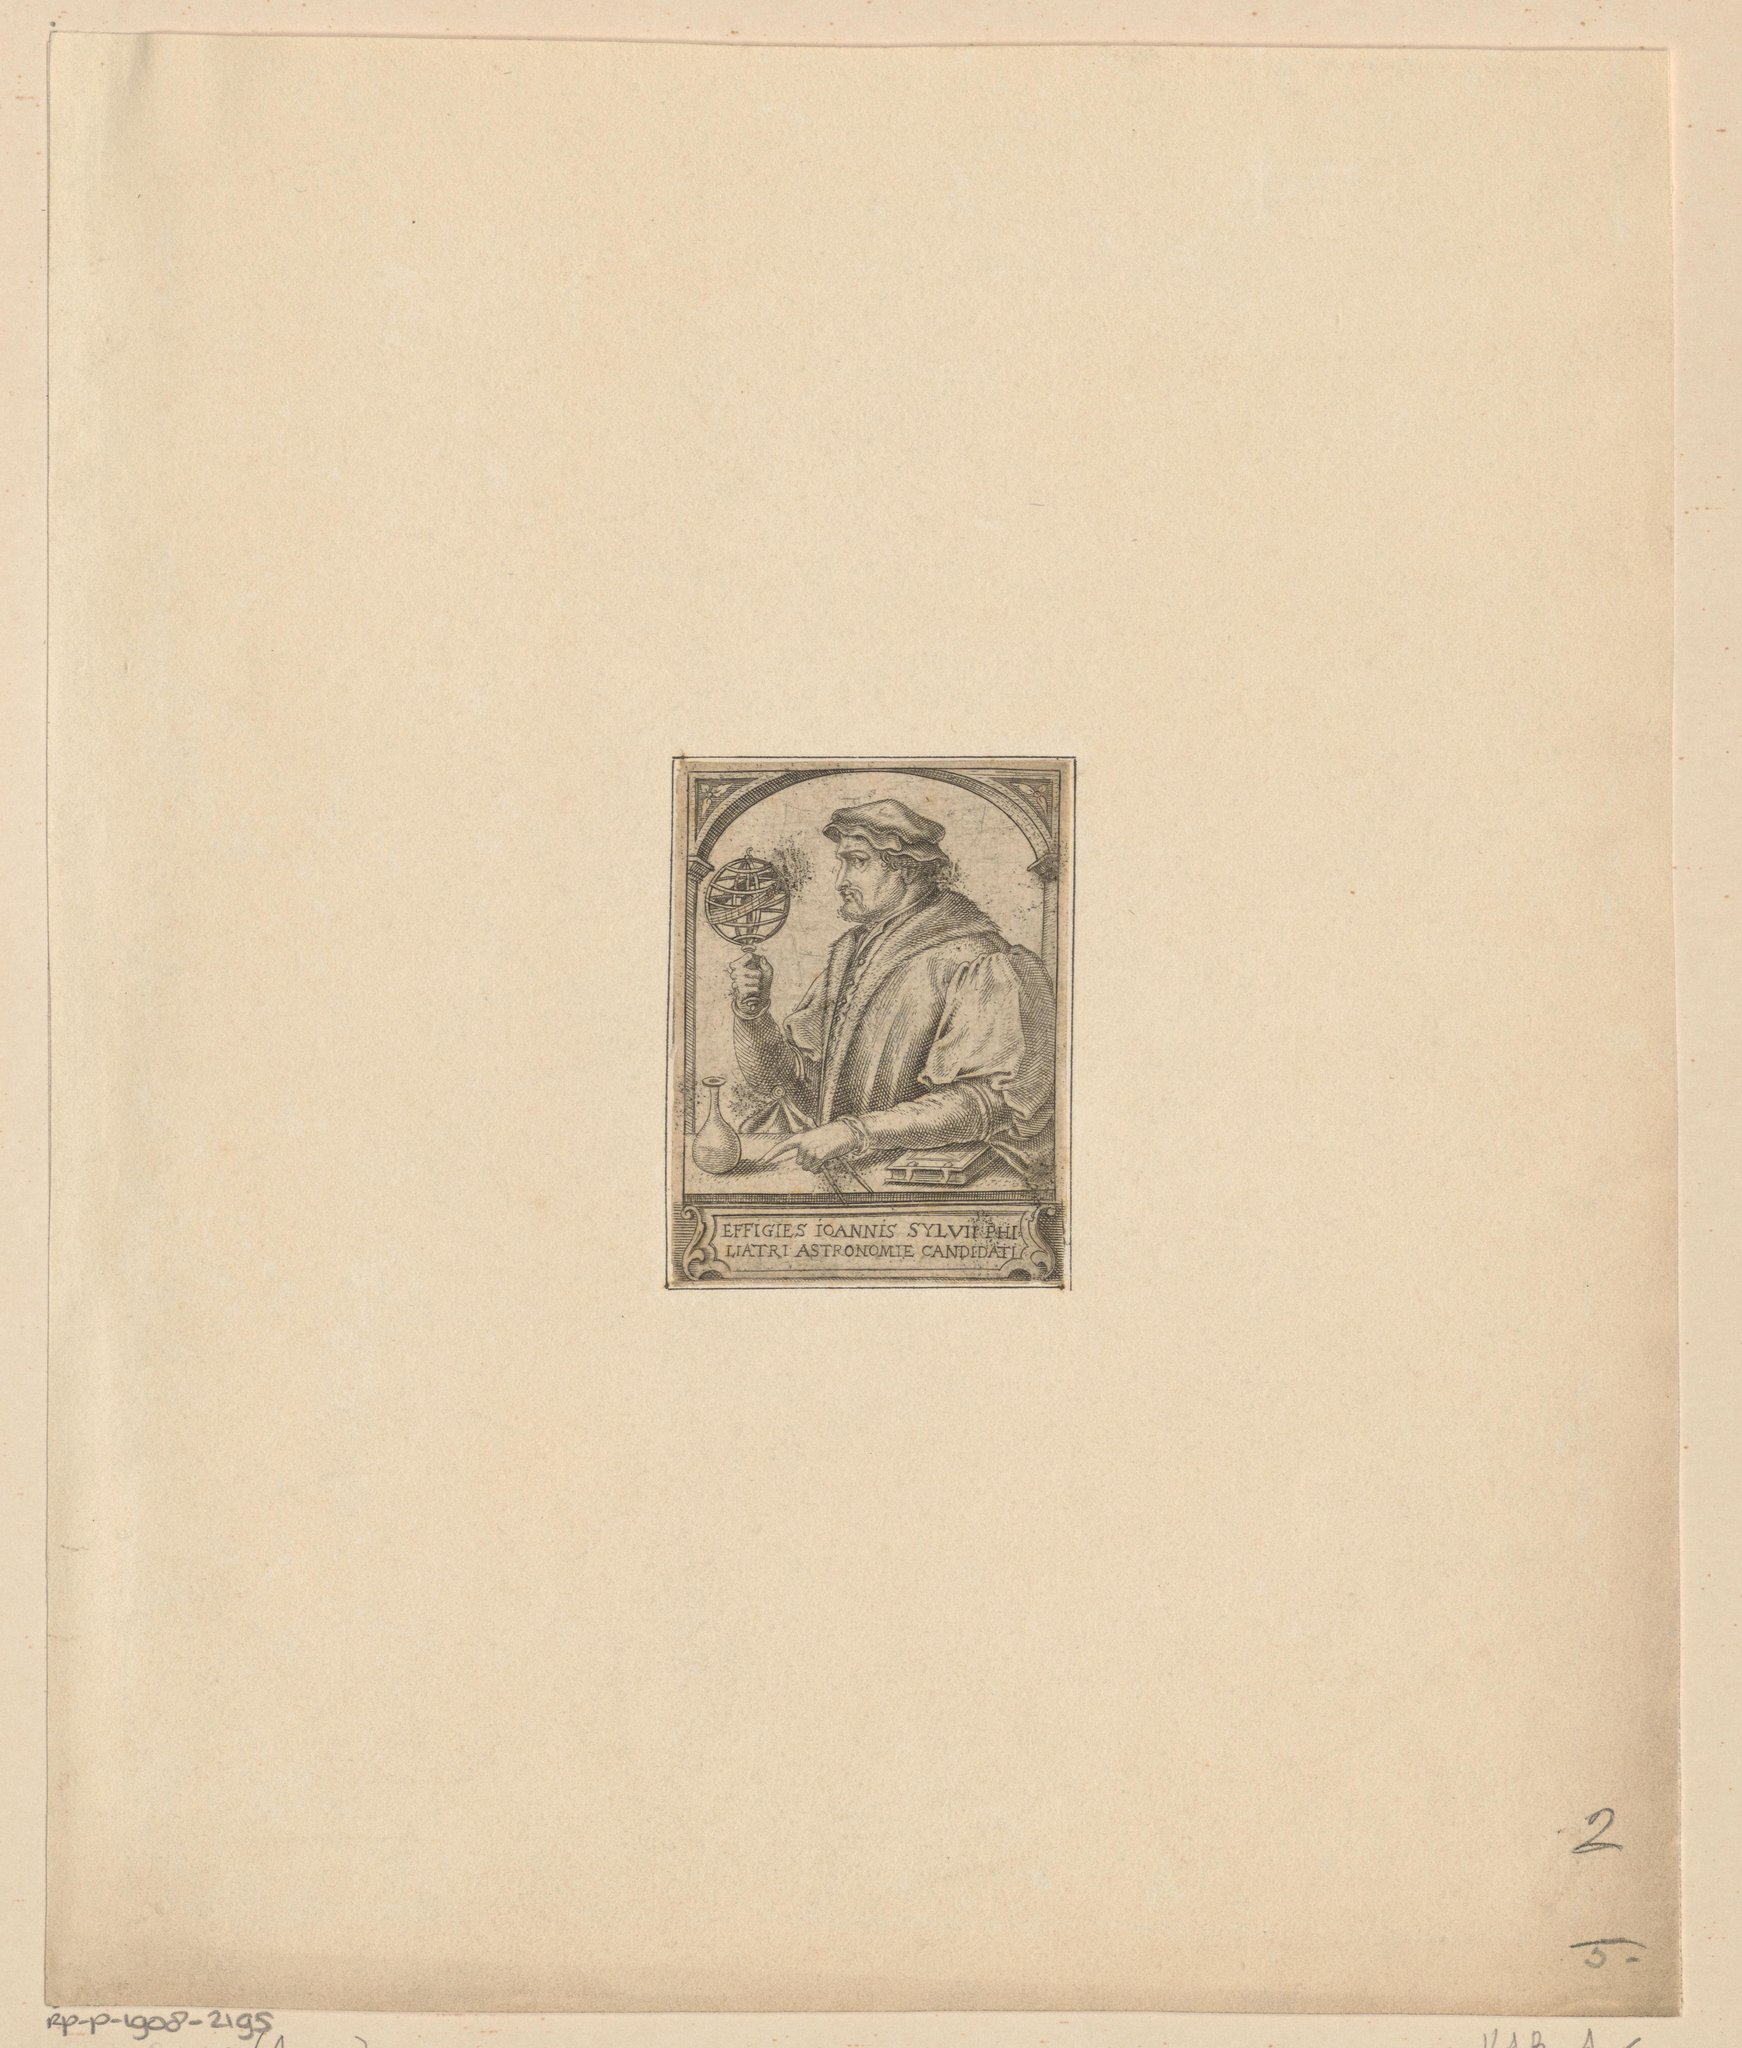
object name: print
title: Portret van Johannes Sylvius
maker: Anonymous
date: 1580-1660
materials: paper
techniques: engraving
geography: germany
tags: historical persons, measuring-instruments, book, armillary sphere, skeleton celestial globe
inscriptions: collector's mark: Lugt 2228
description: Met tweeregelig onderschrift in het Latijn.